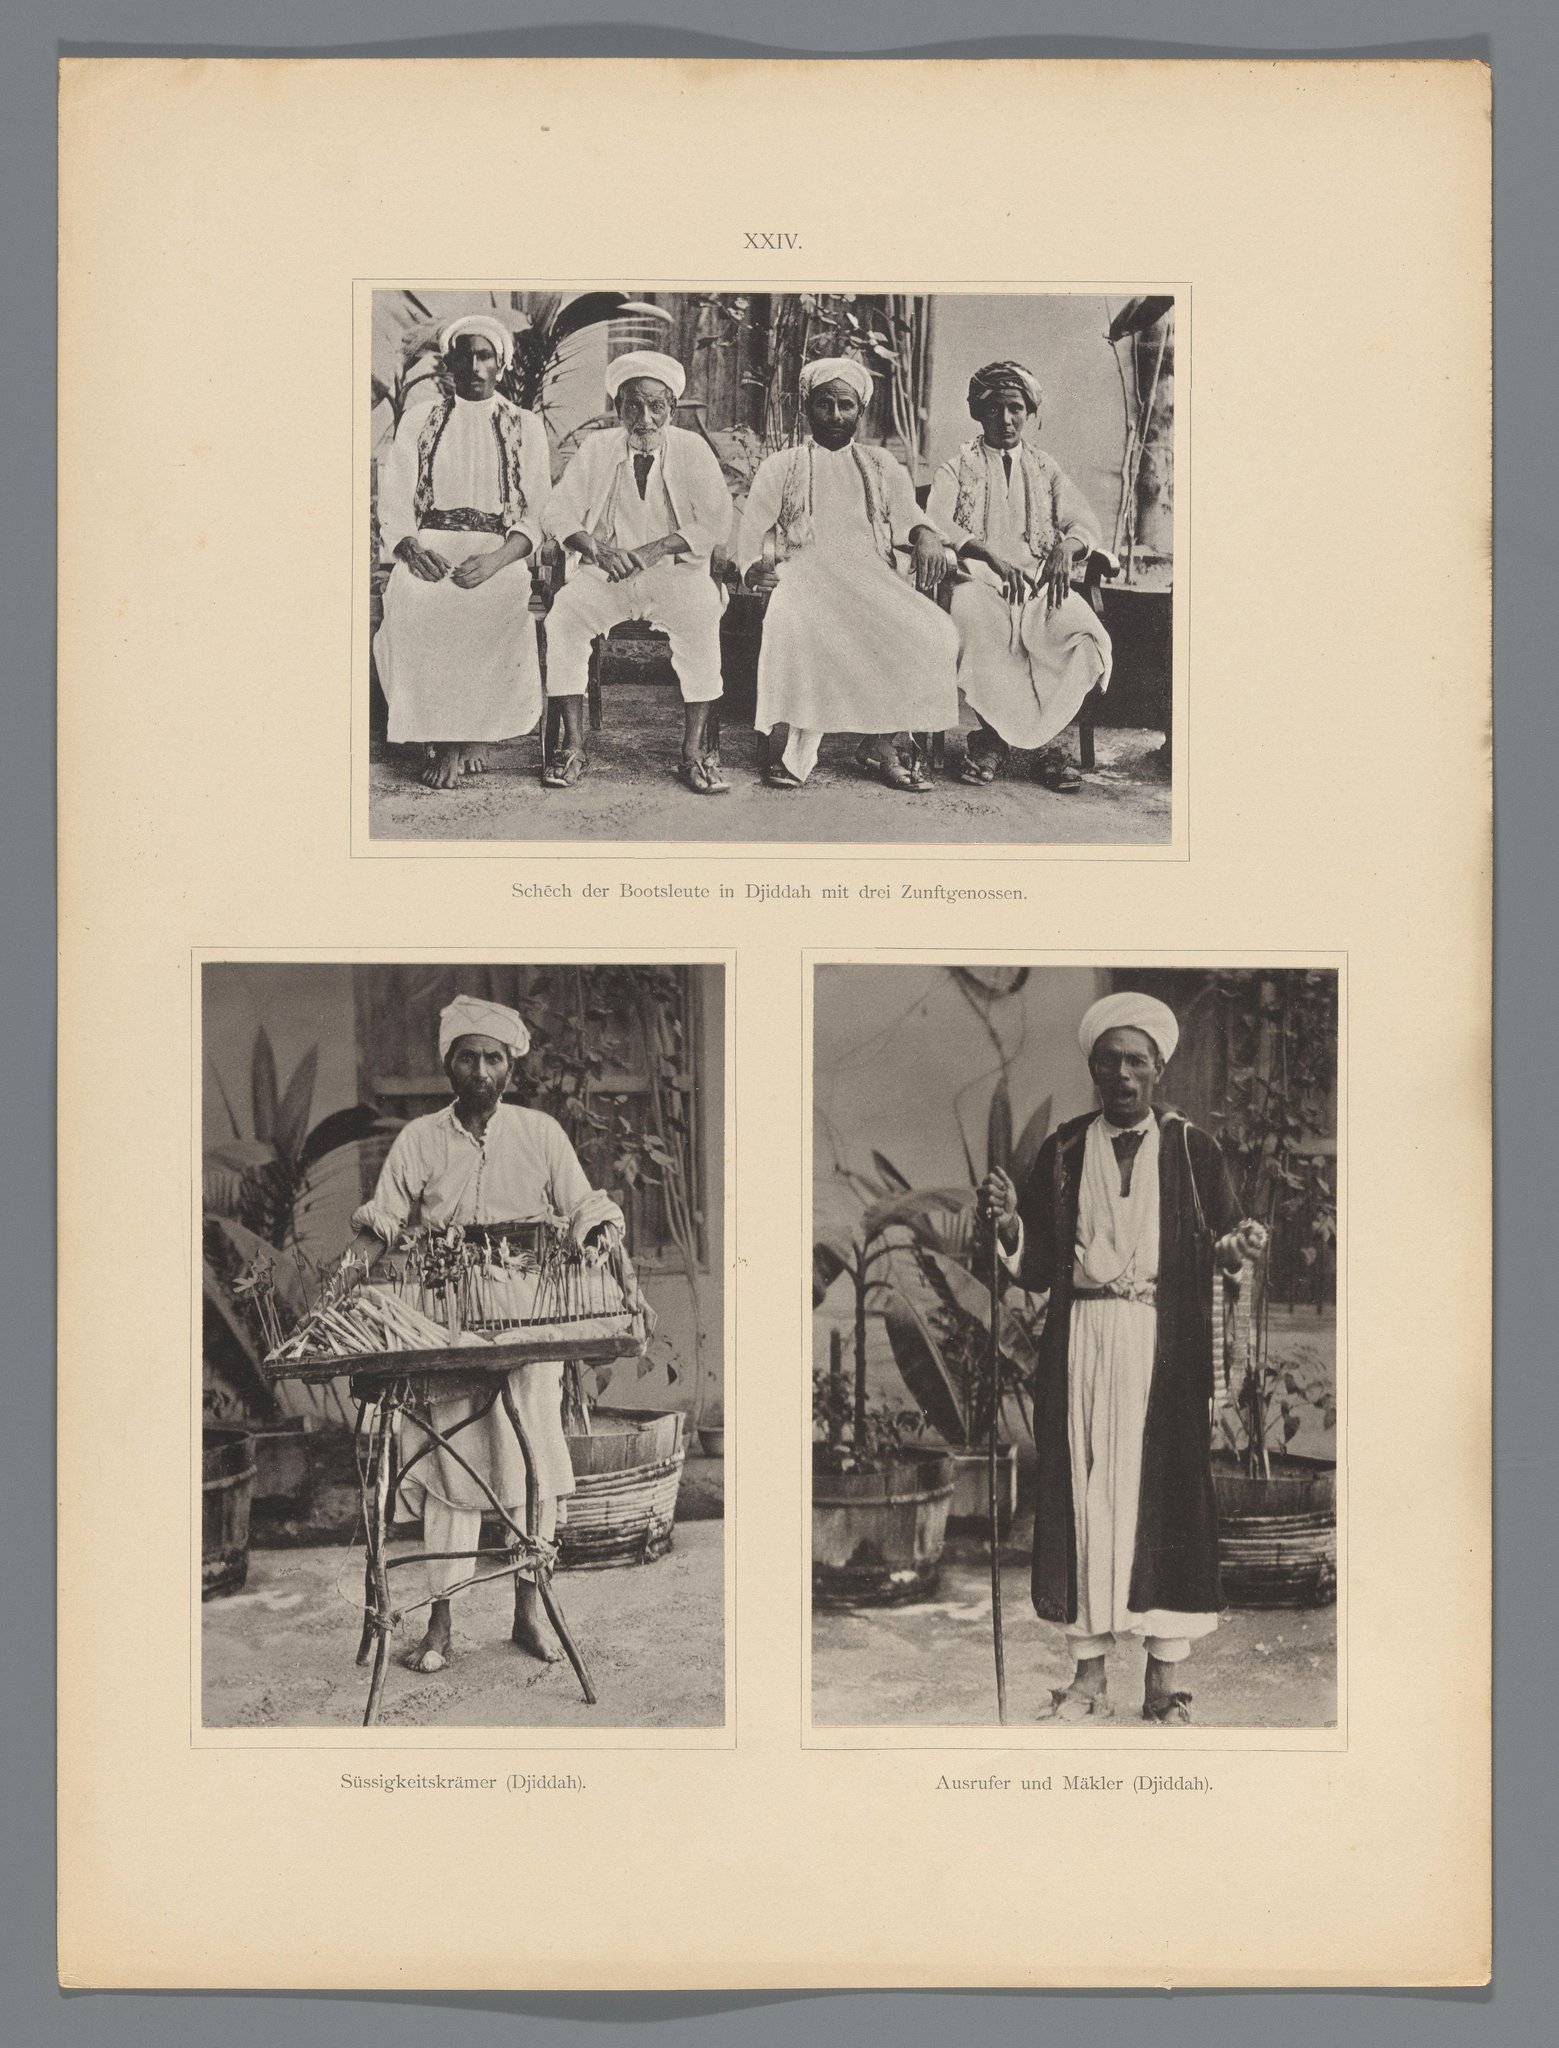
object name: photomechanical print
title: Drie portretten van onbekende mannen, te Djedda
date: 1884-1888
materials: paper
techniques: photograph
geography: djedda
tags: anonymous historical person portrayed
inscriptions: number: ‘XXIV.’